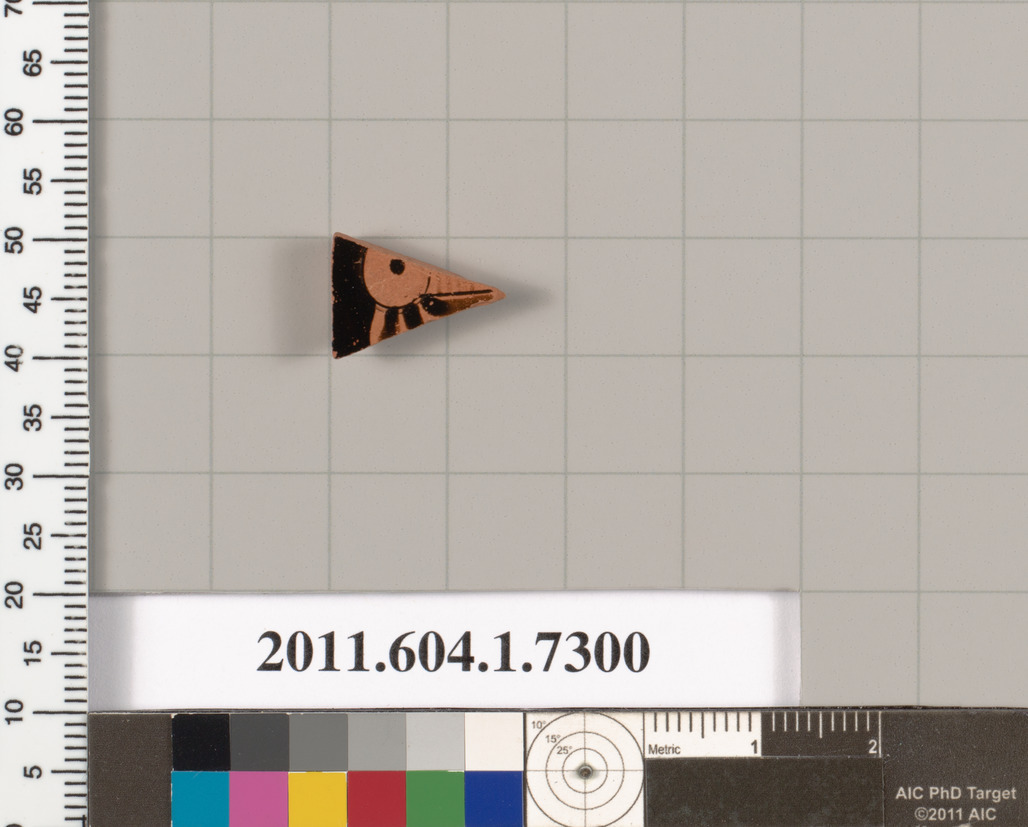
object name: kylix fragment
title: Terracotta fragment of a kylix (drinking cup)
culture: greek, attic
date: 500-480 BCE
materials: terracotta